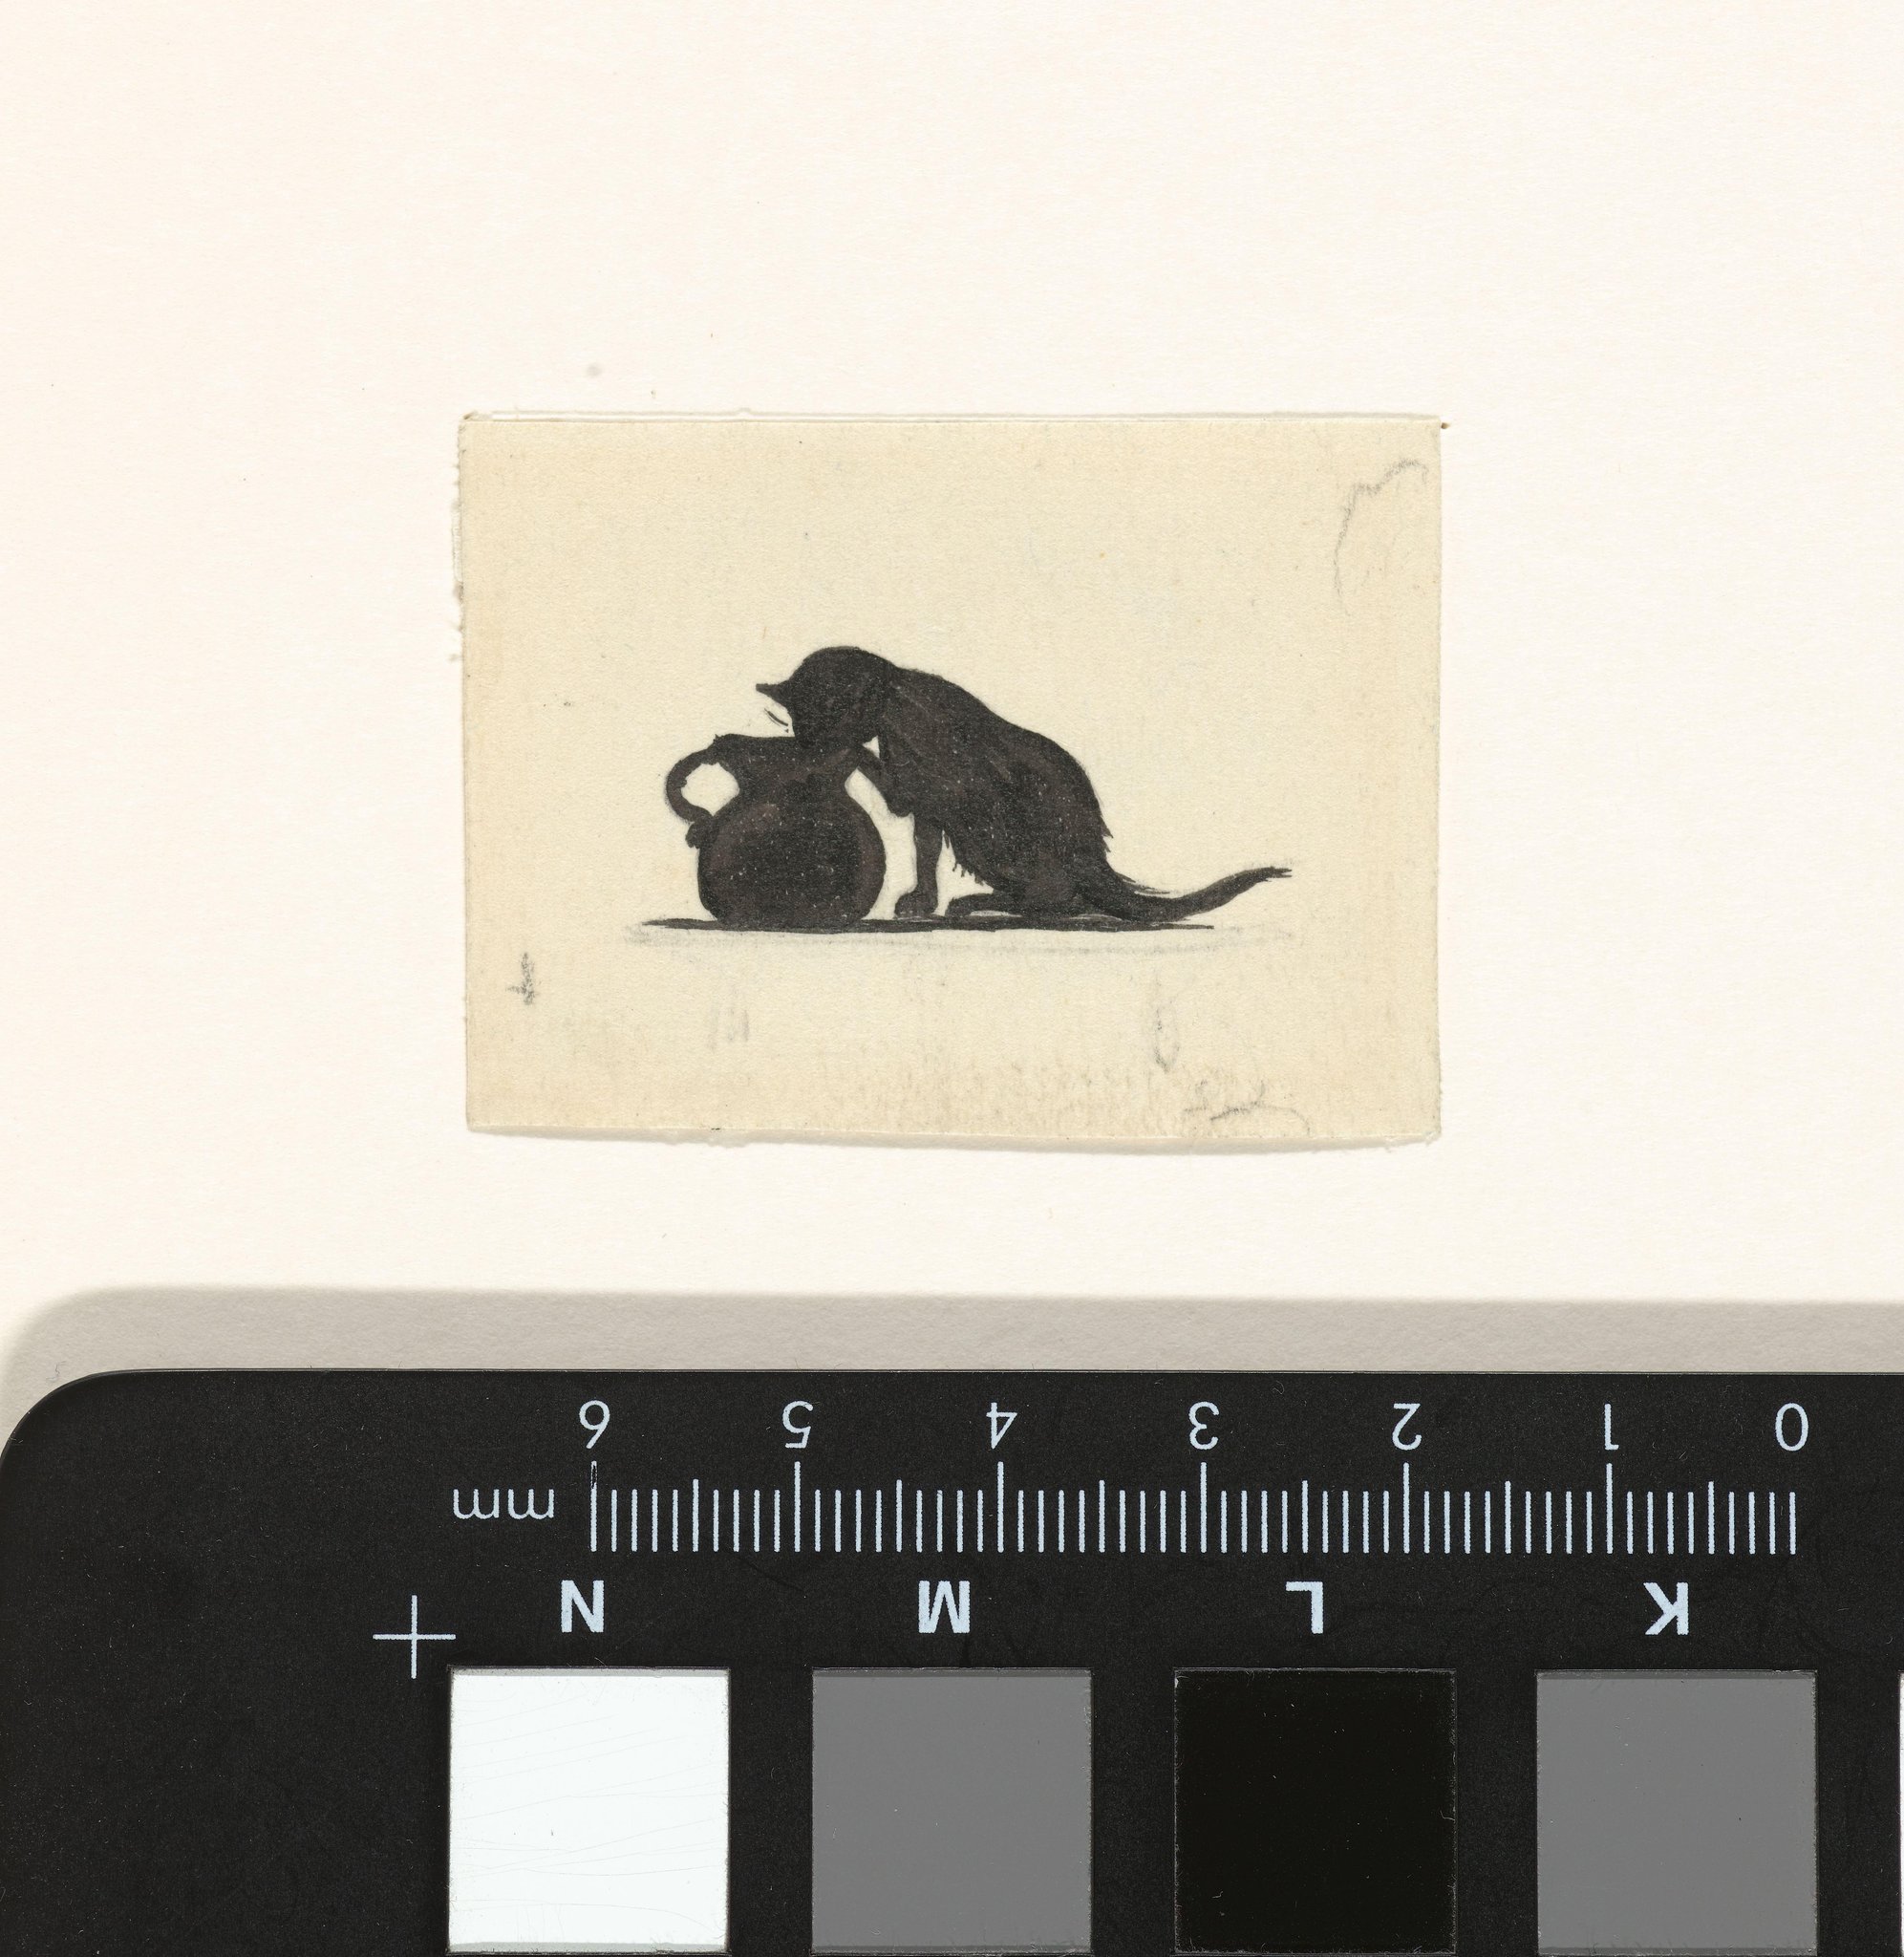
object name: drawing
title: Ontwerp voor illustratie voor In Holland staat een huis: silhouet van kat die uit een kan drinkt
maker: nelly bodenheim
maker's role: designer, draughtsman, print maker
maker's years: 1874-1951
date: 1884-1917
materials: paper, pencil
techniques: brush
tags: 83(van looy, in holland staat een huis)